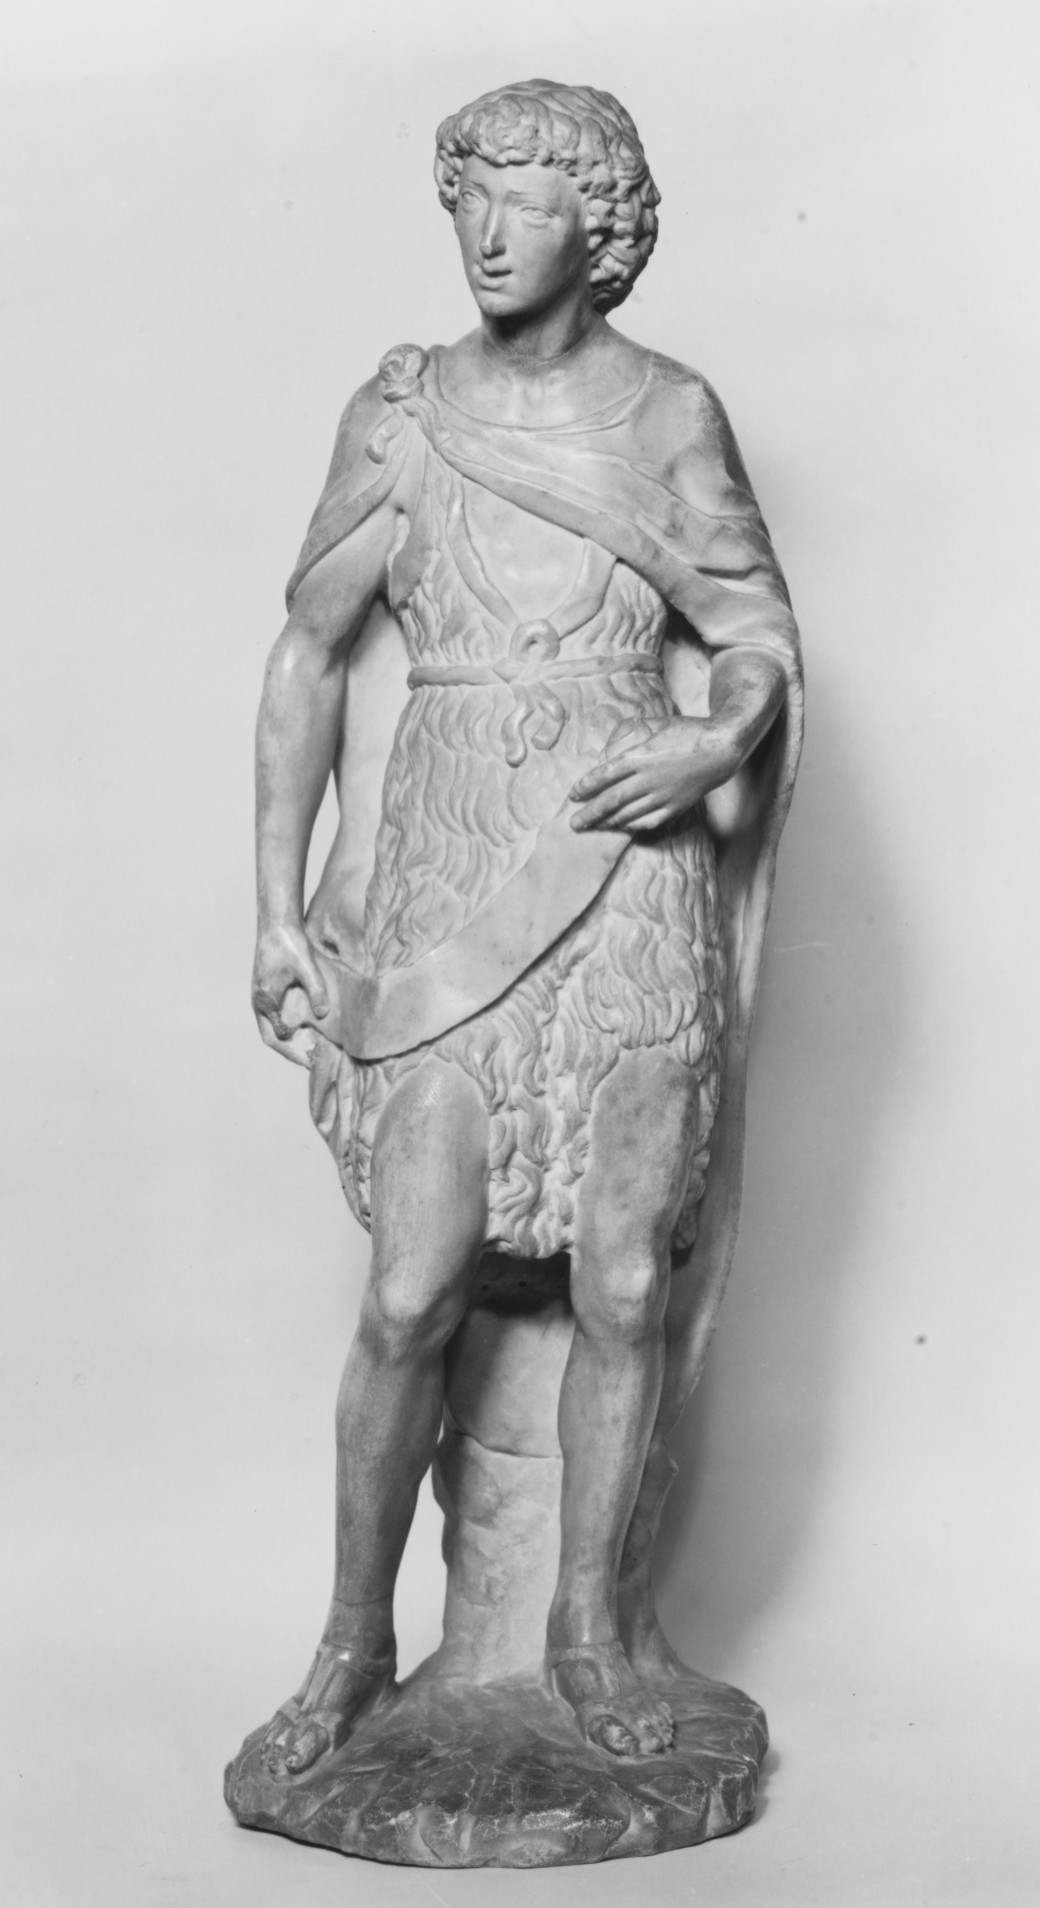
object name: statue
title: Saint John the Baptist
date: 1476-1500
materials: marble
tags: saint john the baptist